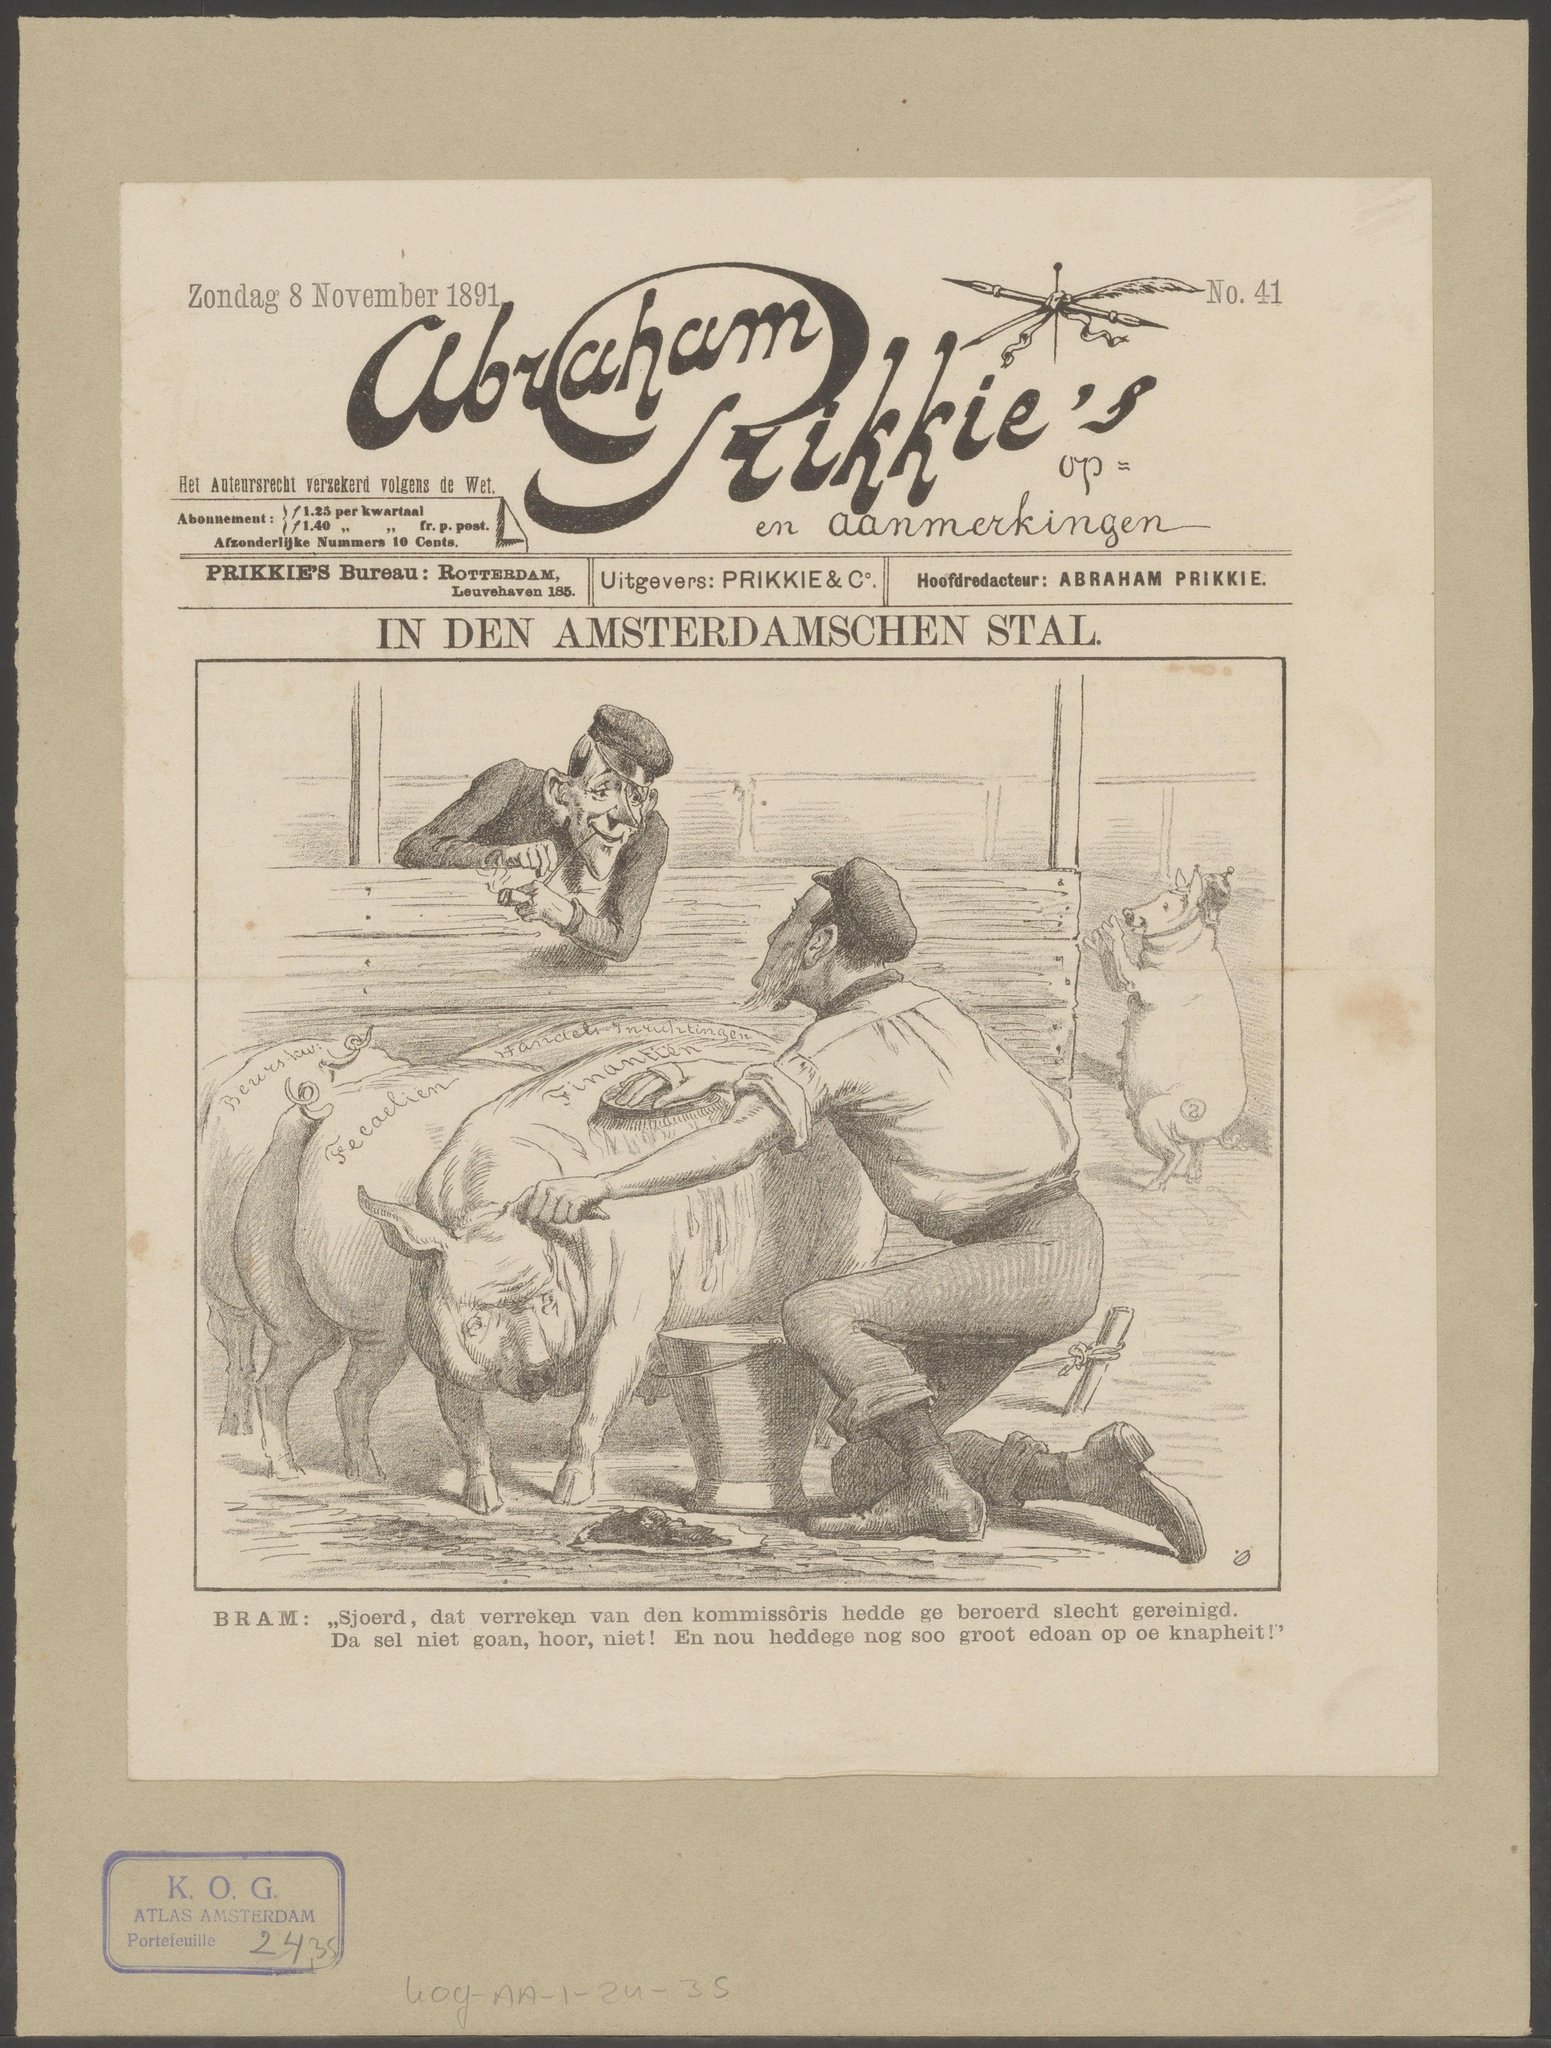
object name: cartoon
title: Titelpagina voor: Abraham Prikkie's op- en aanmerkingen, 8 november 1891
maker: hendrik jan carel linse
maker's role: draughtsman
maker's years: 1843-1906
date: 1891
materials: paper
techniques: letterpress printing, lithograph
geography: netherlands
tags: harlingen, politician, pig, stall, stable, amsterdam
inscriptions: collector's mark: Lugt 1641b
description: Titelpagina voor: Abraham Prikkie's op- en aanmerkingen (1891), nr. 41, 8 november 1891.